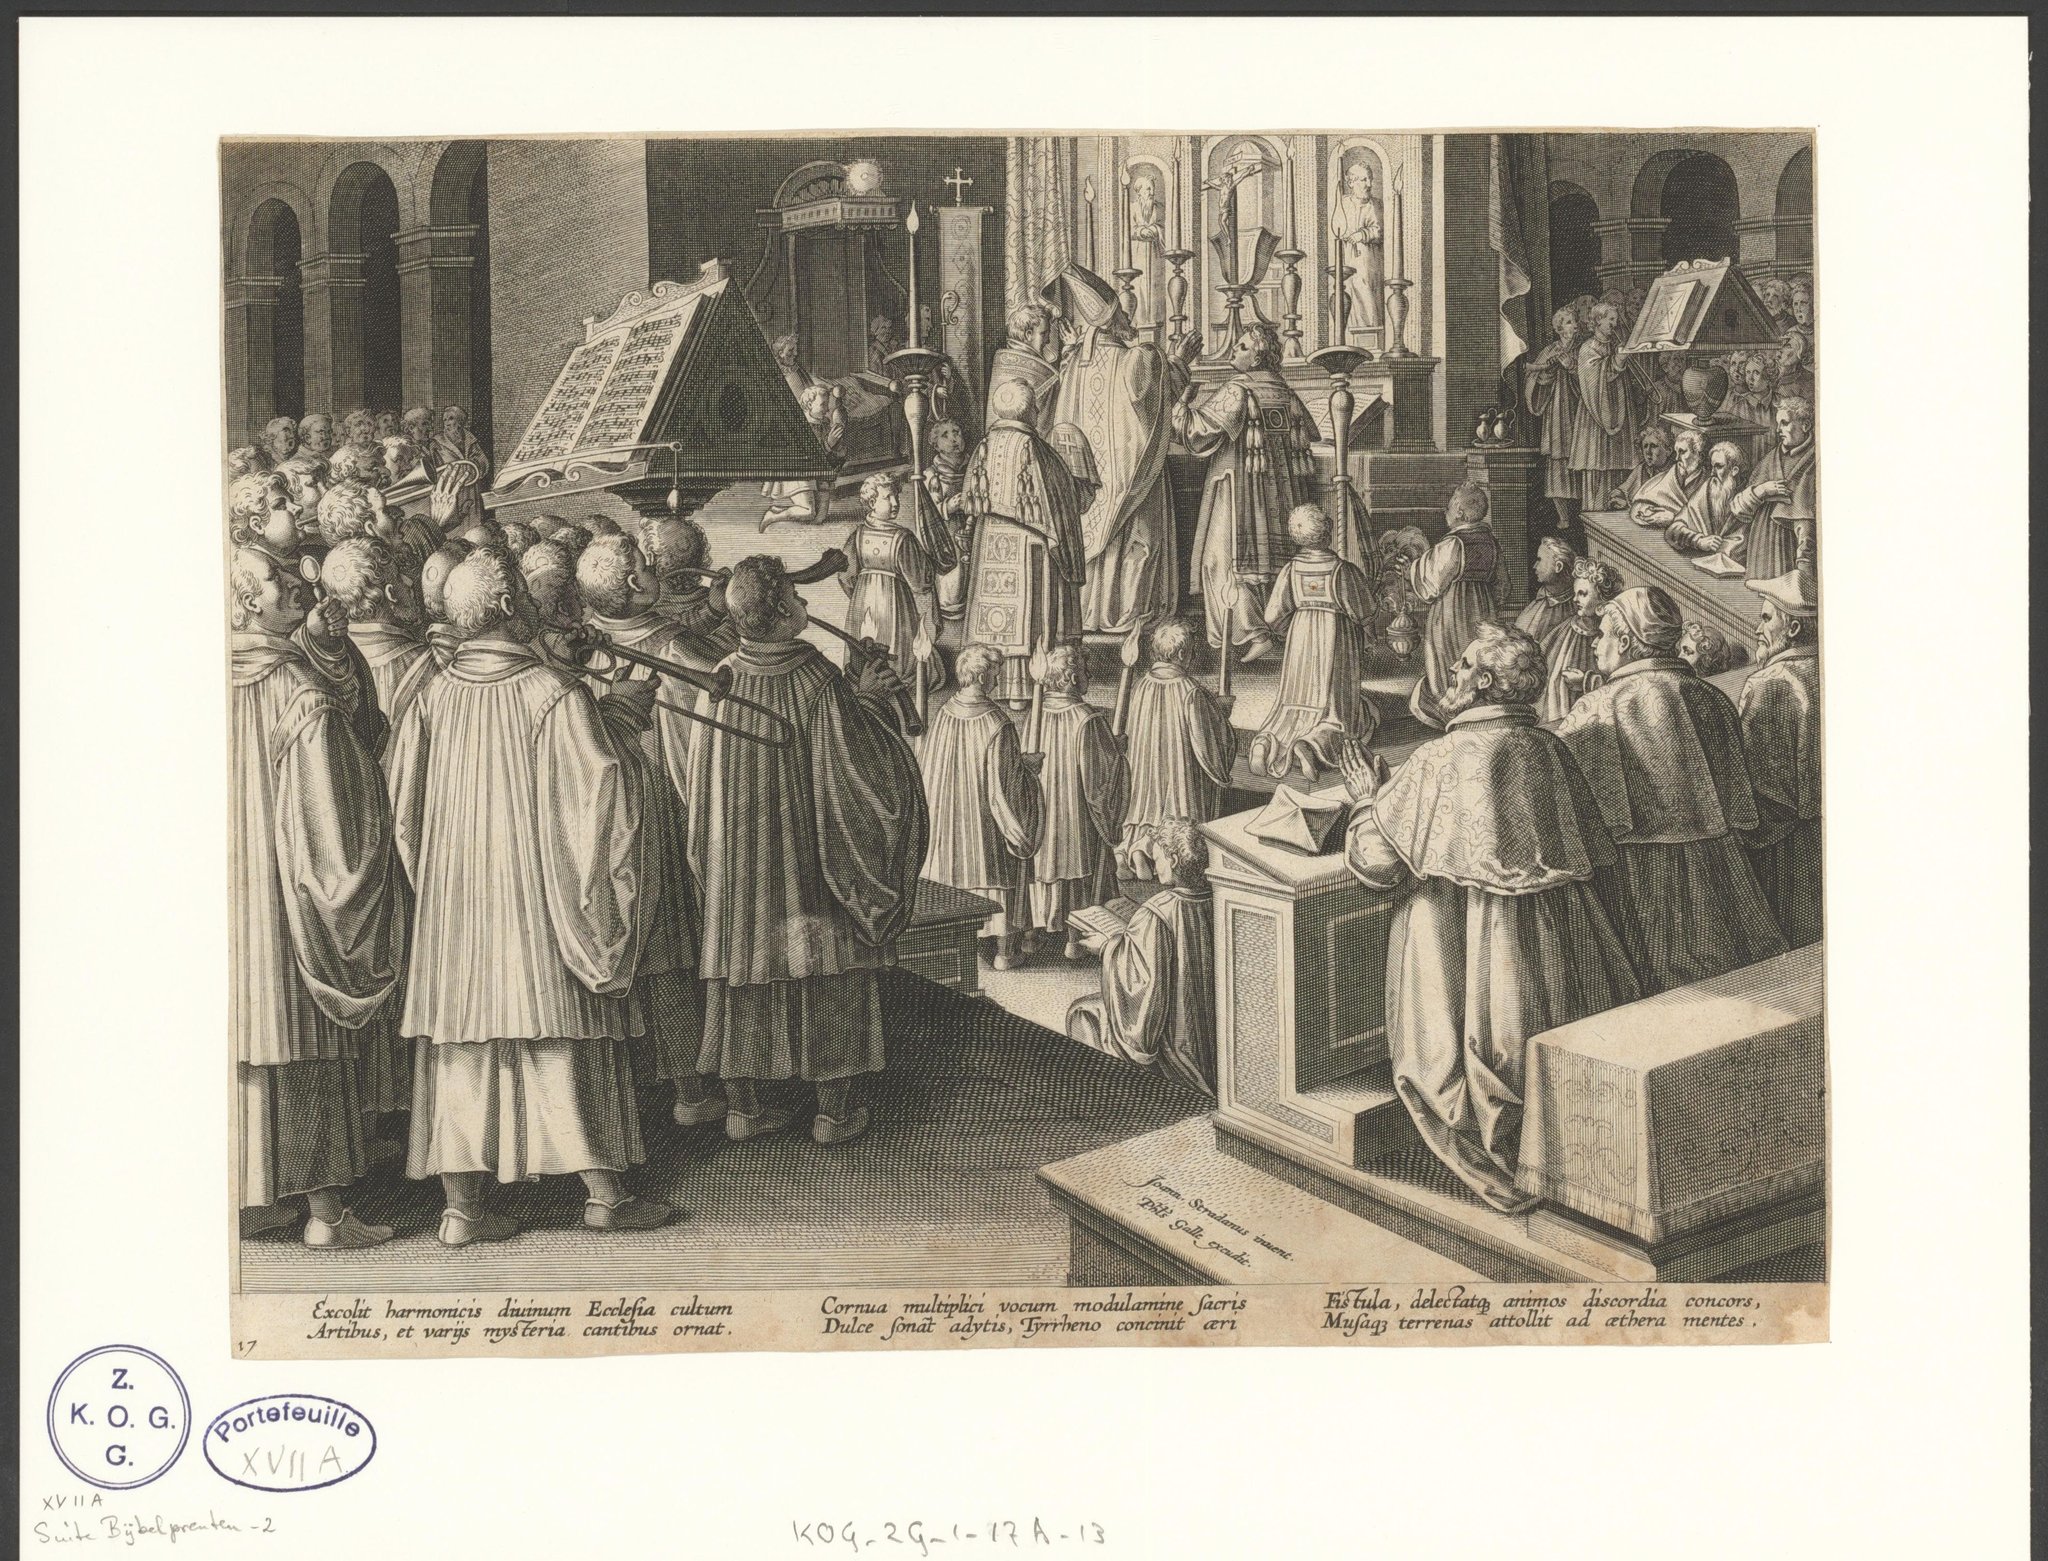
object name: print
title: Encomium musices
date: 1587-1592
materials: paper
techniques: engraving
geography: antwerp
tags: musical instruments; group of musical instruments, making music in church, holy mass (divine service, especially of roman catholic church), printed edition of musical score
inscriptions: stamp, collector's mark: Lugt 1641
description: Muzikale viering van de heilige mis met musicerende mannen (hoorns, trombones) en lezenaren met koorboeken. Onder de voorstelling zes versregels in het Latijn. Linksonder genummerd: 17. Onderwerpsrubrieken binnen de Atlas Zeden en Gewoonten: Muziek en muziekinstrumenten: Muziekinstrumenten op bijbelprenten.